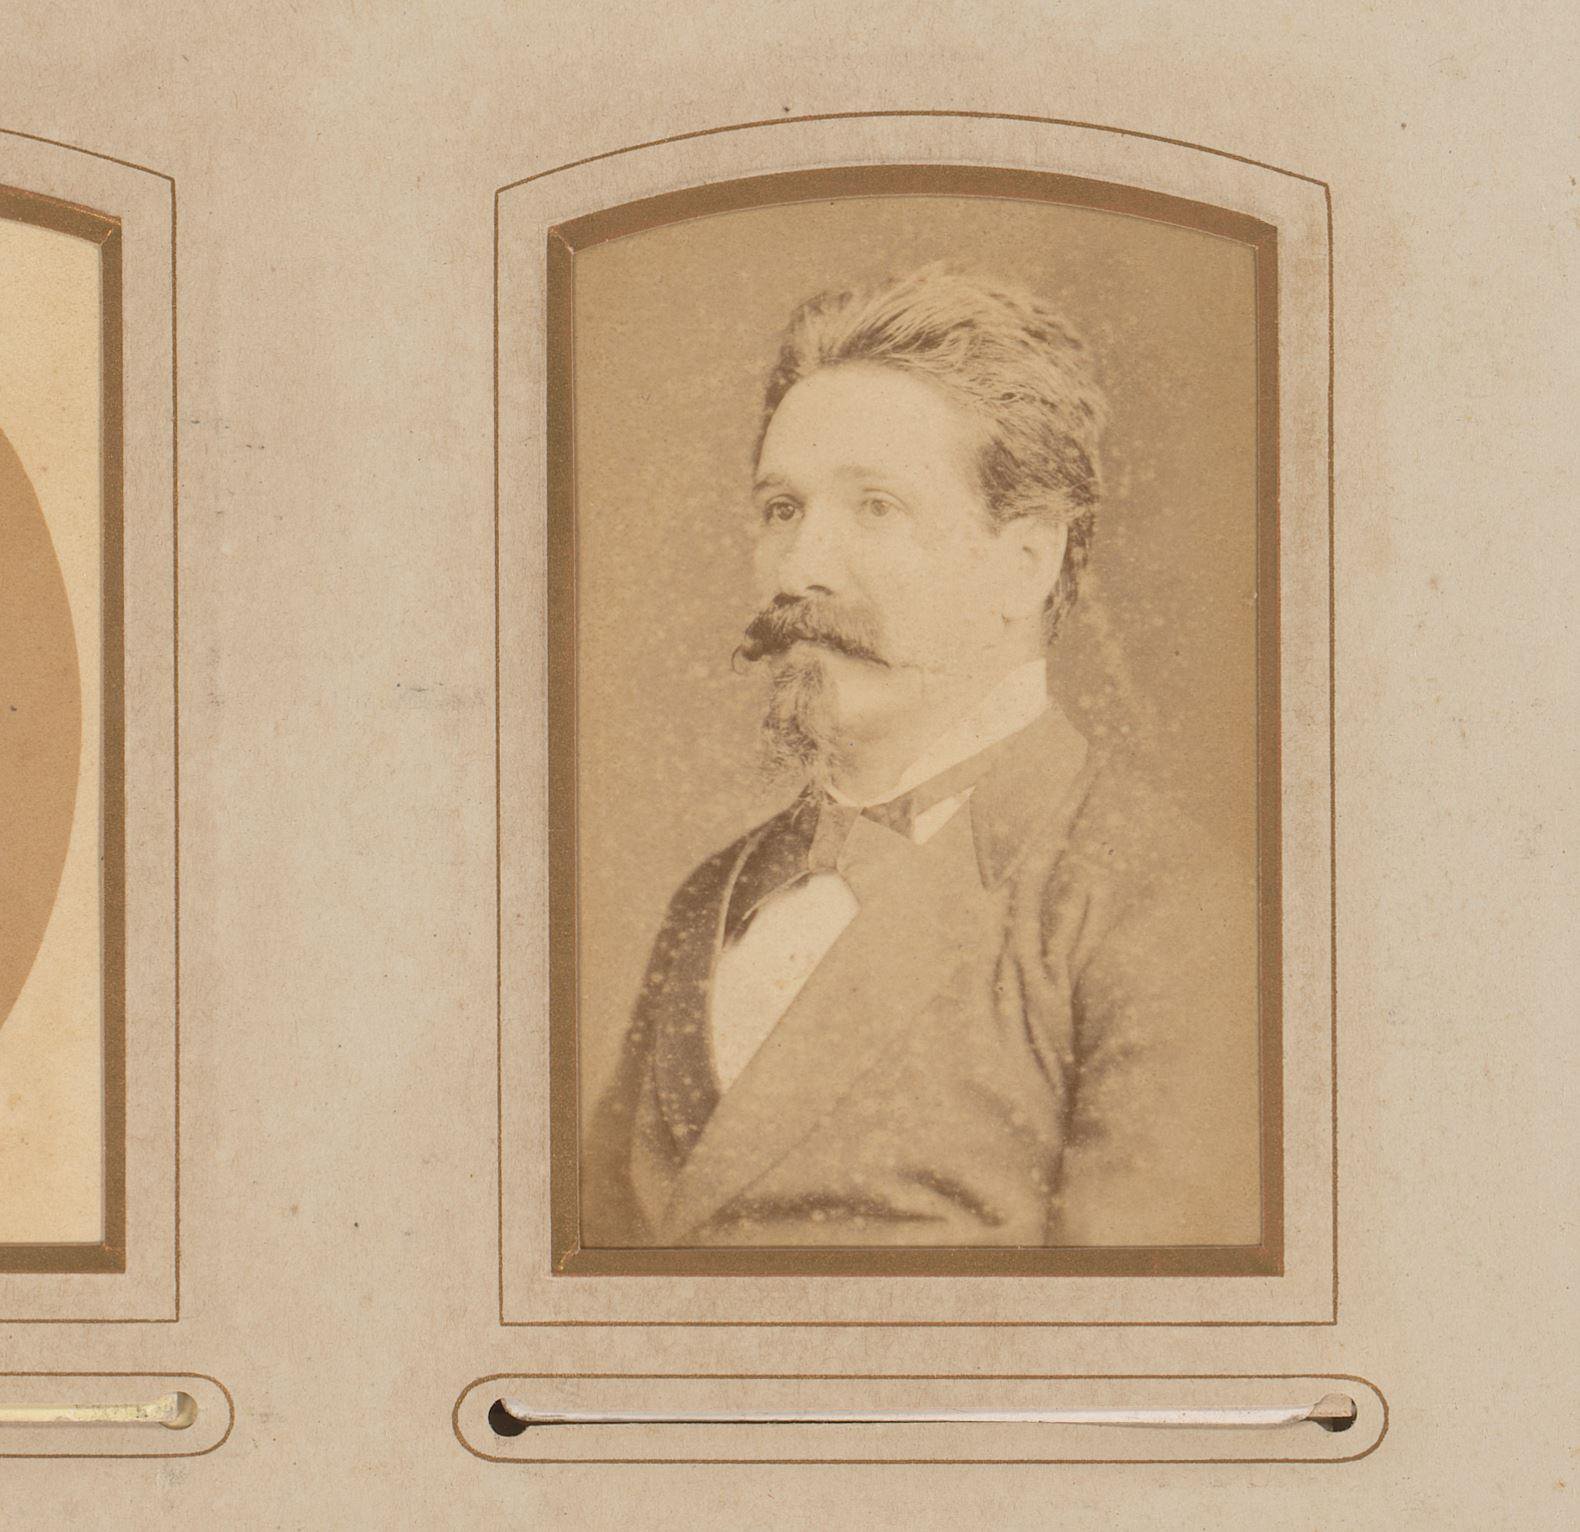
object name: carte de visite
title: Portret van een man met snor en baard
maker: herman salzwedel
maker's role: fotograaf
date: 1880-1905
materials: cardboard, photographic support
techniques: albumen print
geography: surabaya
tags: moustache, historical persons, beard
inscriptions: inscription: ‘(...)/ ATELIER/ van/ H. SALZWEDEL/ SOERABAYA/ JAVA.’